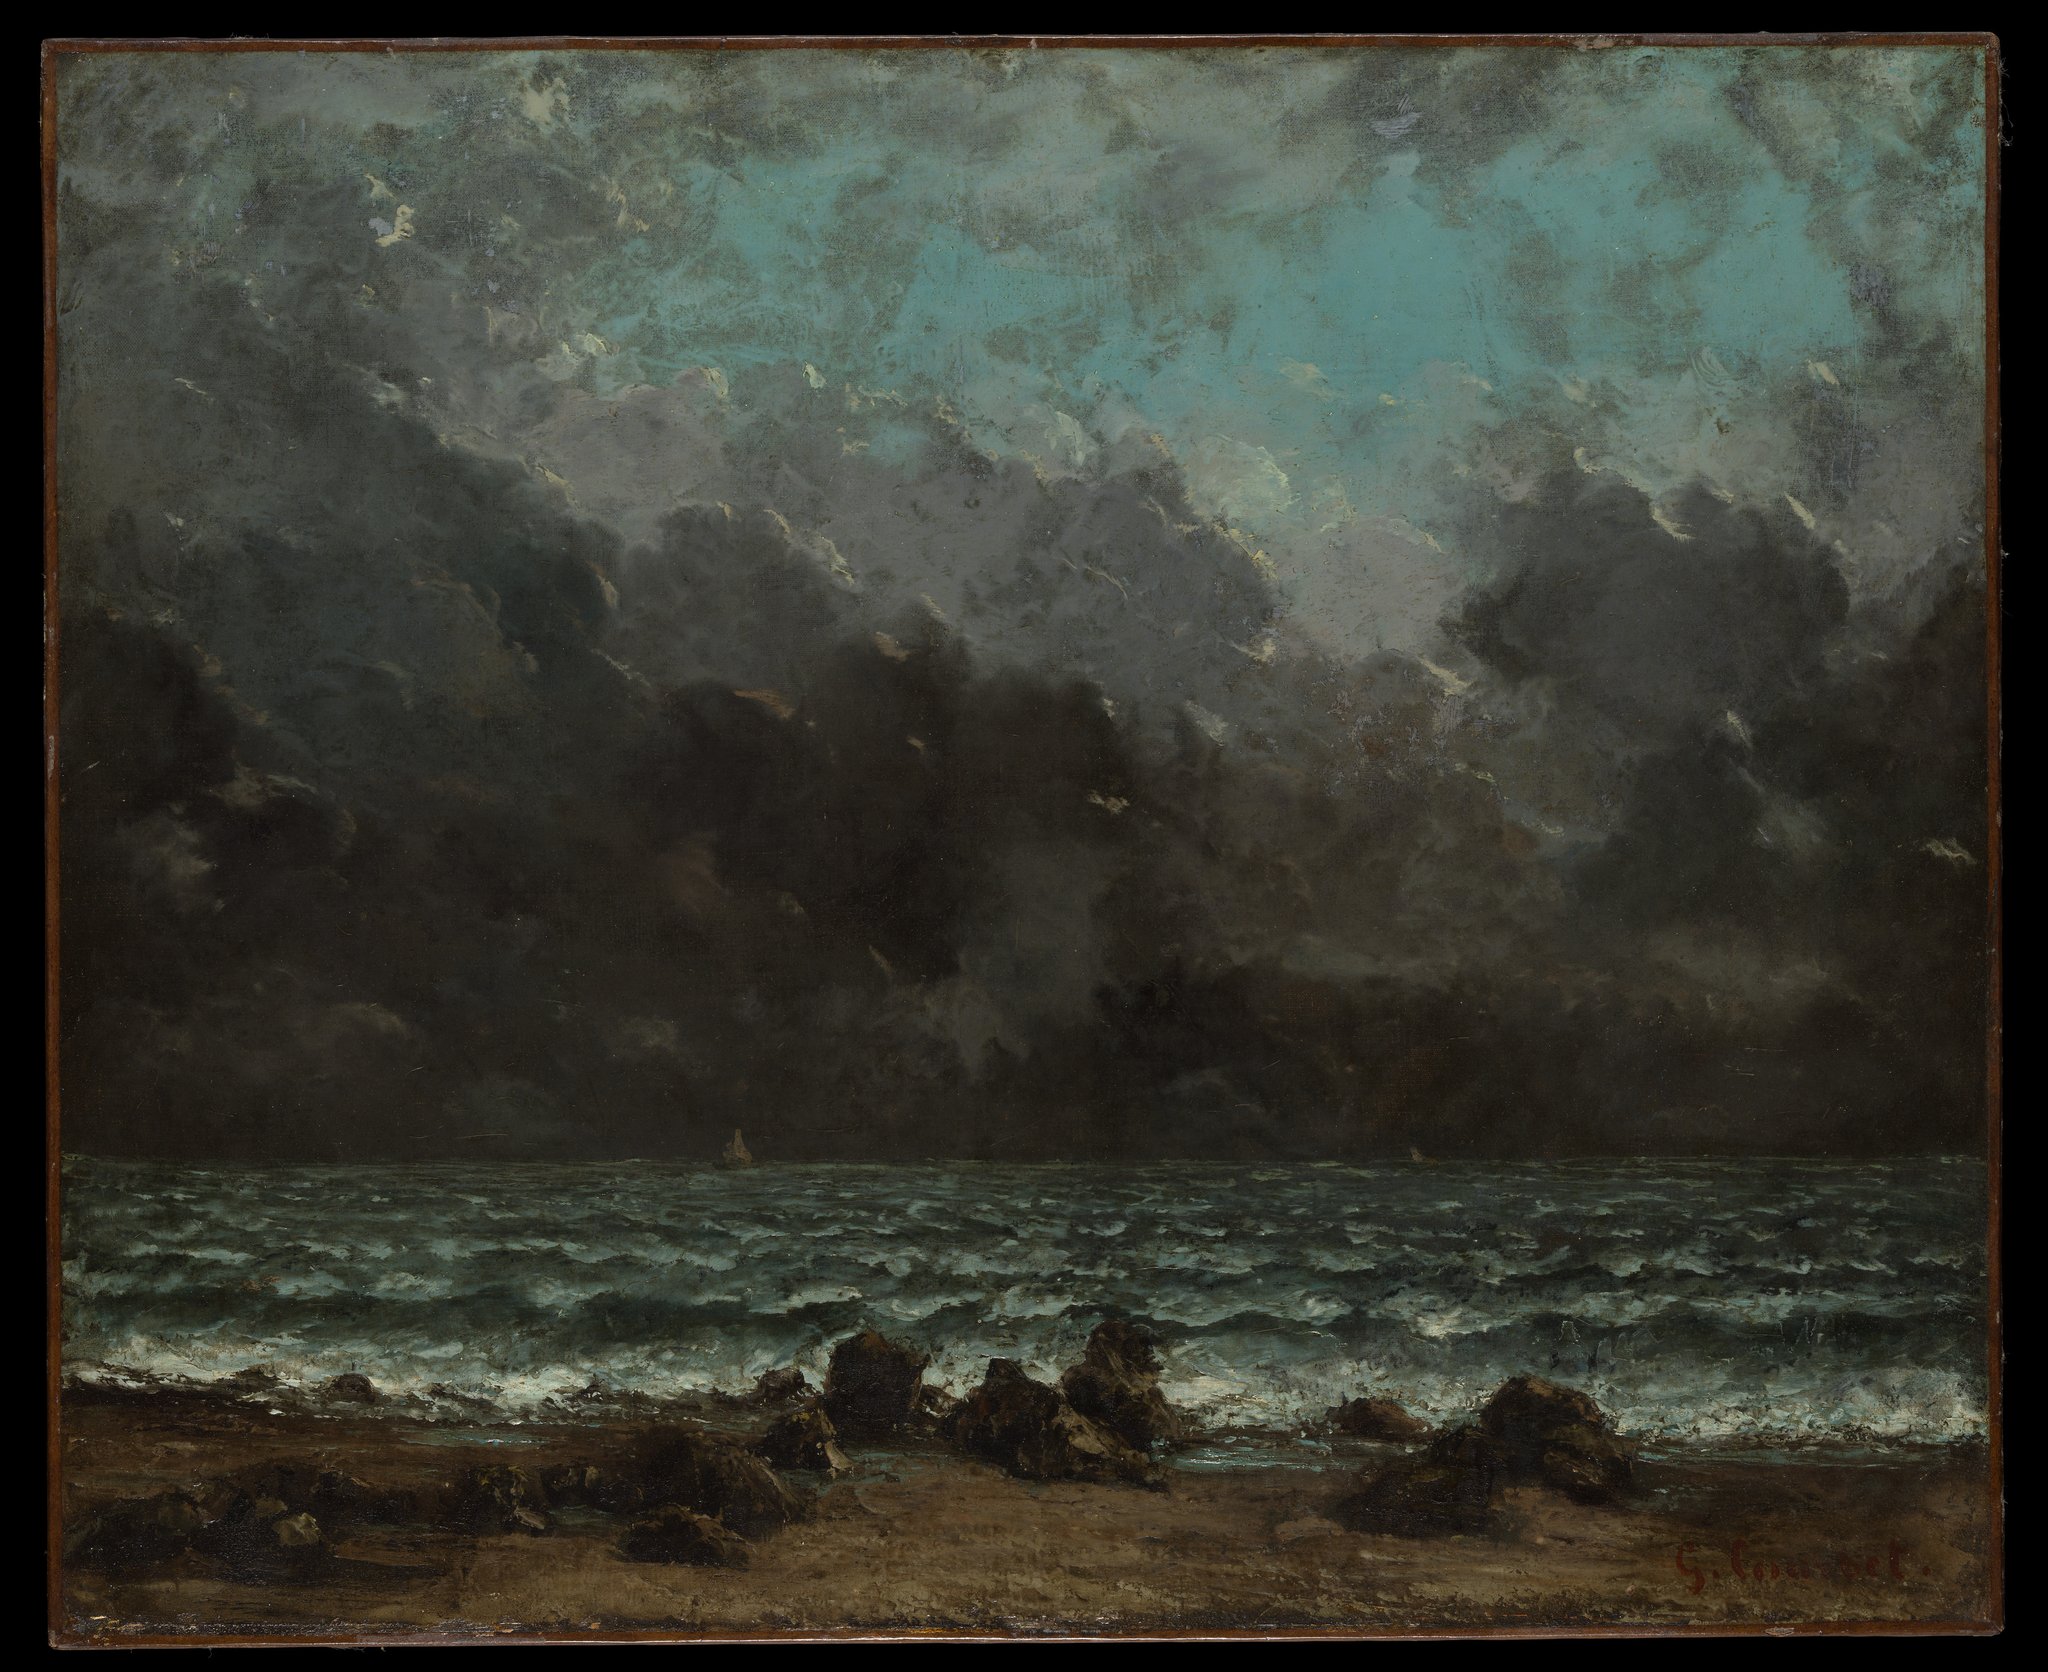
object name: painting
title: The Sea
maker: gustave courbet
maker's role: artist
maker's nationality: french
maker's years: 1819-1877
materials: canvas, oil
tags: sky,seascapes,clouds